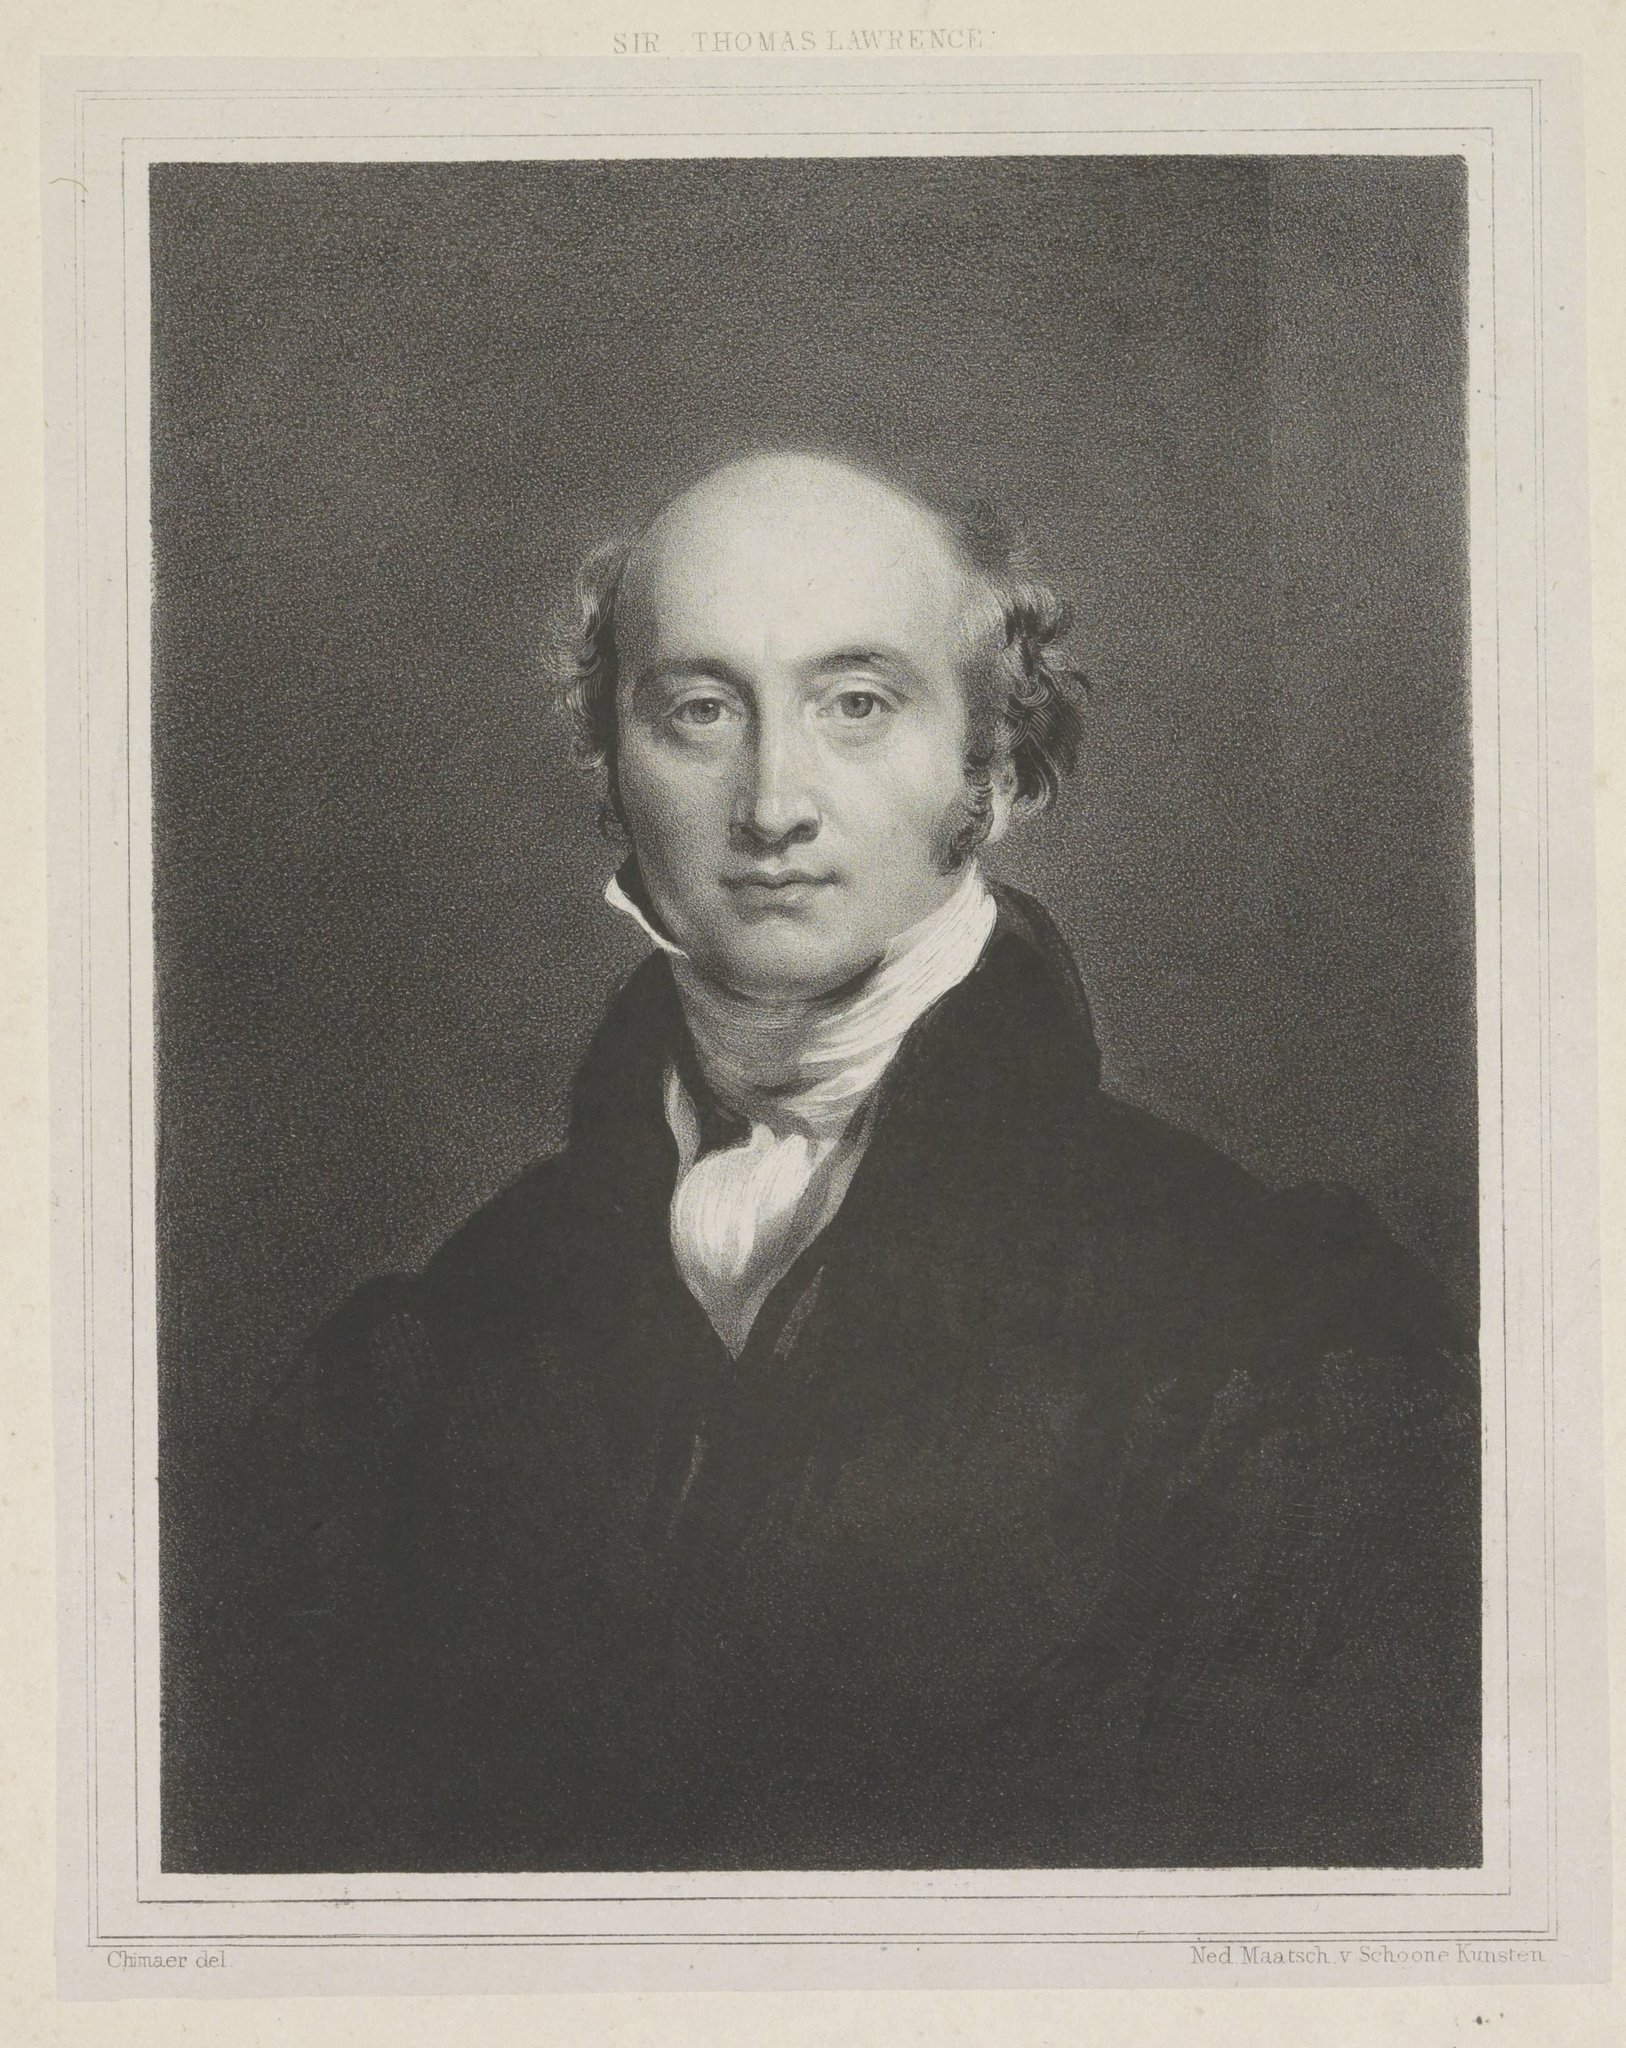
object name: print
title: Portret van George Canning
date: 1840-1843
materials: paper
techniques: lithograph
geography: netherlands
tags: london, historical persons (+ head (and shoulders) (portrait))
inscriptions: collector's mark: Lugt 2228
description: De geportretteerde draagt een zwarte jas met daaronder een witte das en opstaande witte kraag.